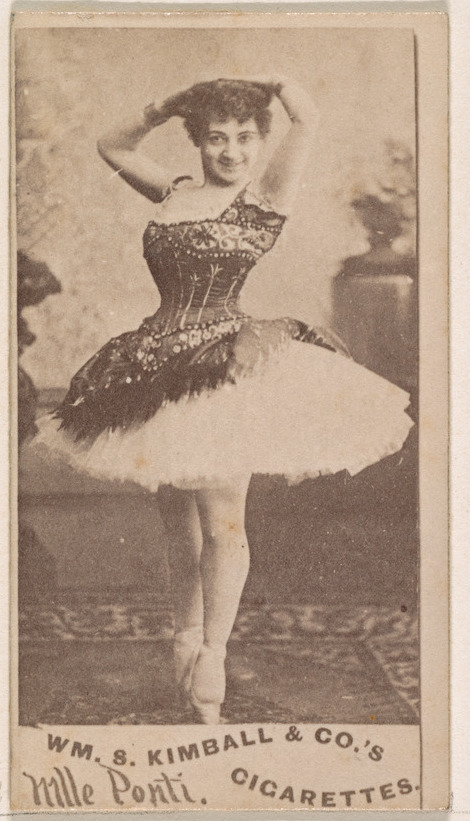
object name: photograph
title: Mlle. Ponti, from the Actresses series (N203) issued by Wm. S. Kimball & Co.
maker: william s. kimball & company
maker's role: publisher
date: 1889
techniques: color lithograph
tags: portraits,women,actresses